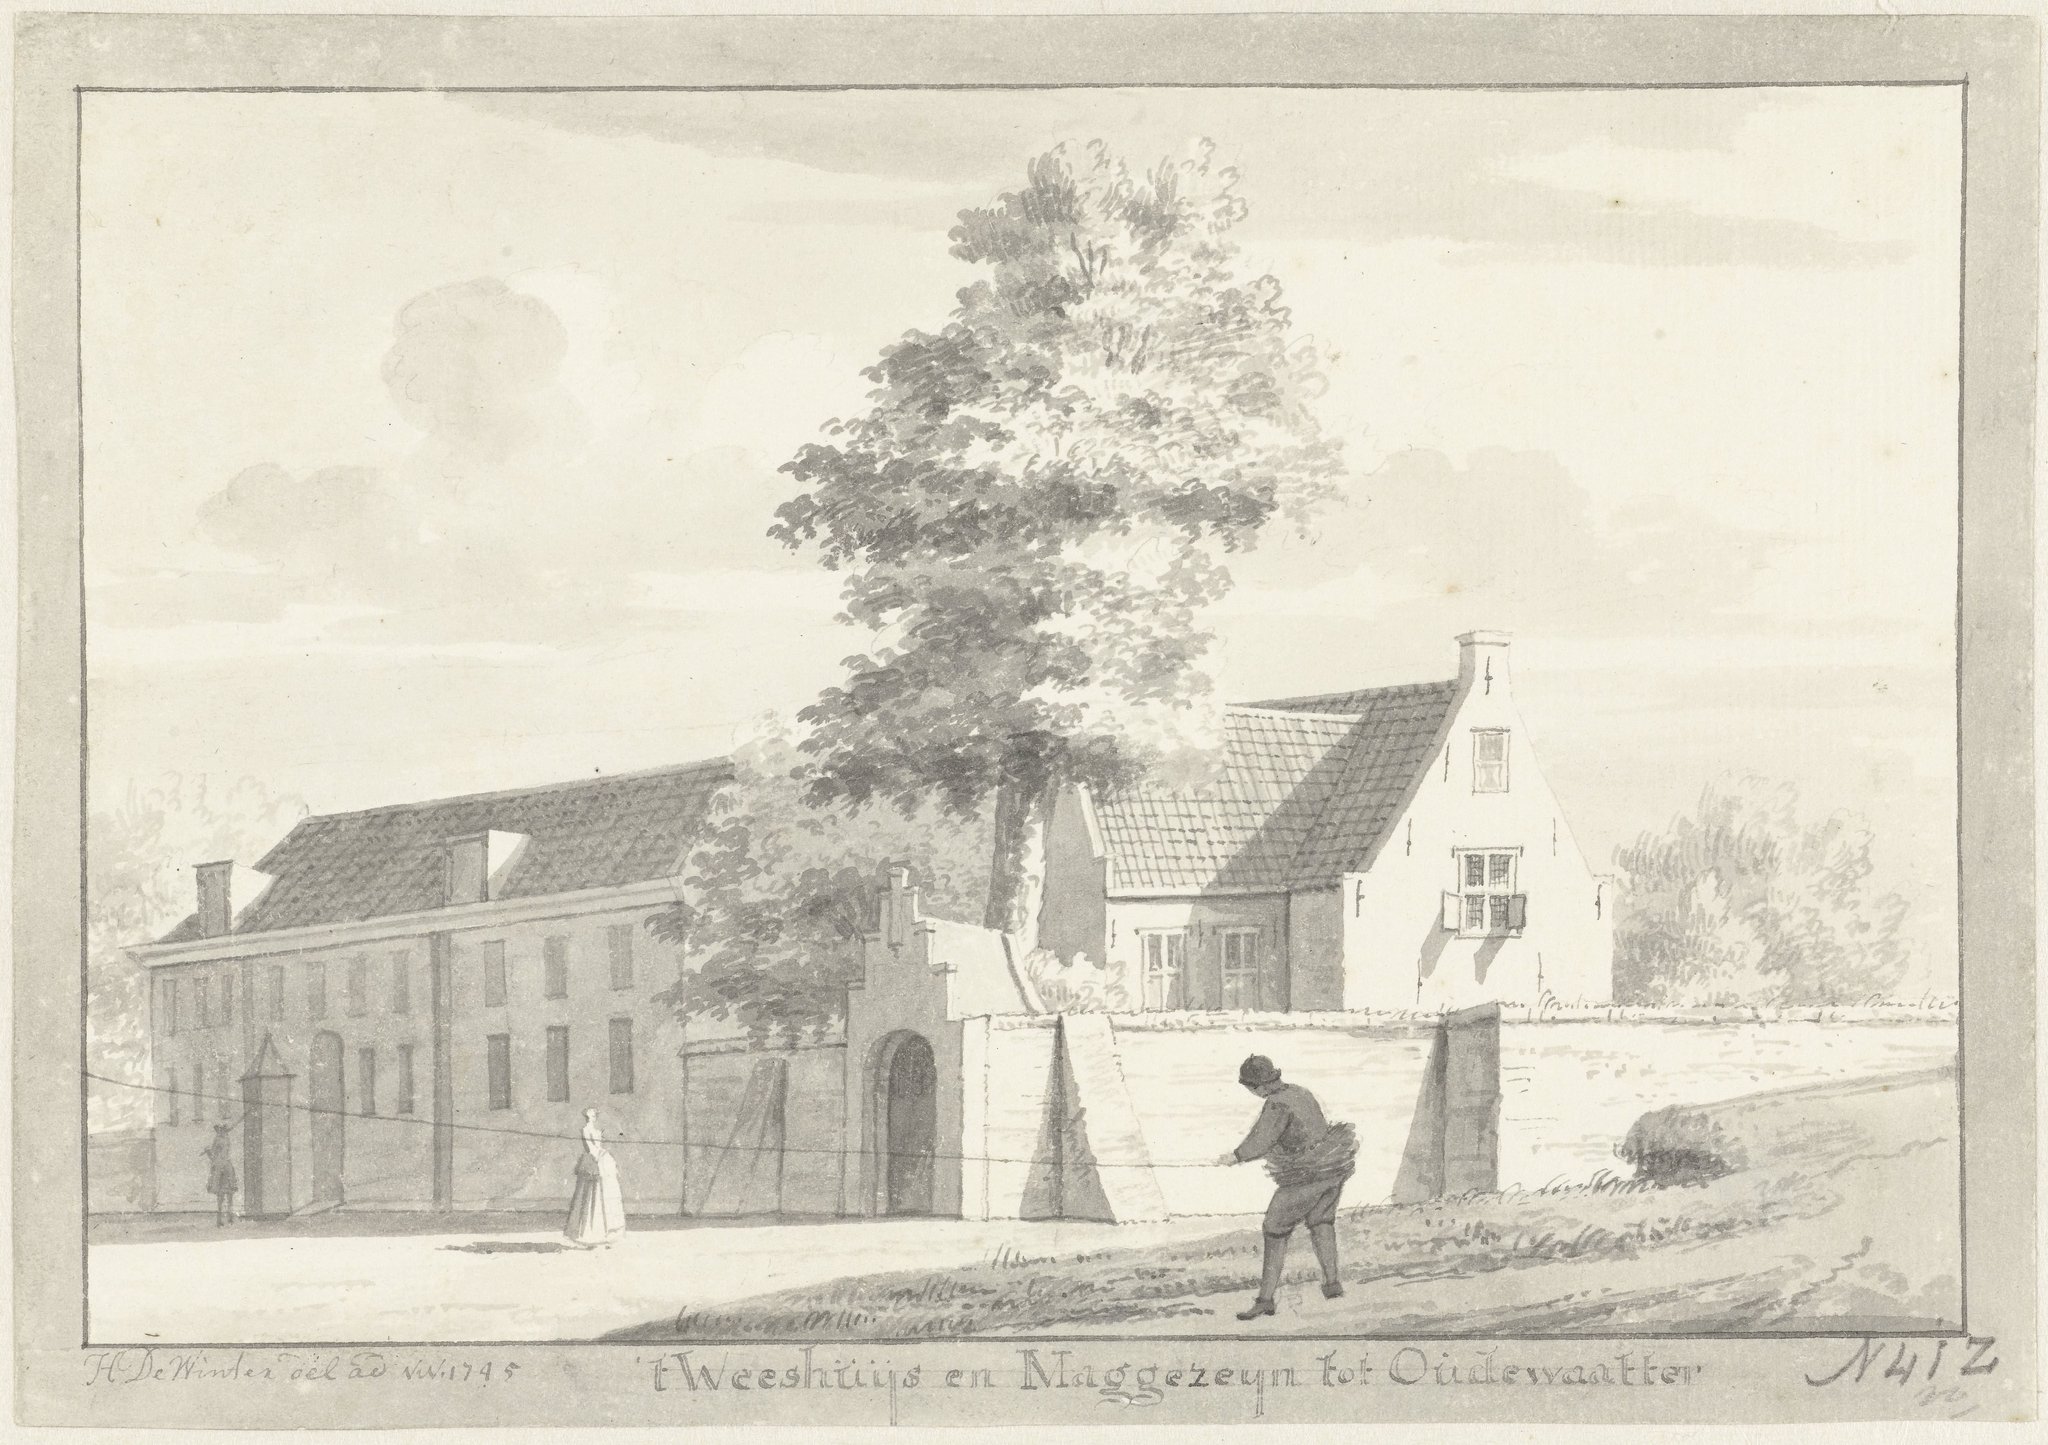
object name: drawing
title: Het Weeshuis en het Magazijn te Oudewater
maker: hendrik de winter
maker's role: draughtsman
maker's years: 1717-1790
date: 1745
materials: ink, paper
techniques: brush, pen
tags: orphanage, street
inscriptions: inscription: ‘H De Winter del ad viv: 1745 't Weeshuijs en Maggezeyn tot Oudewaatter’